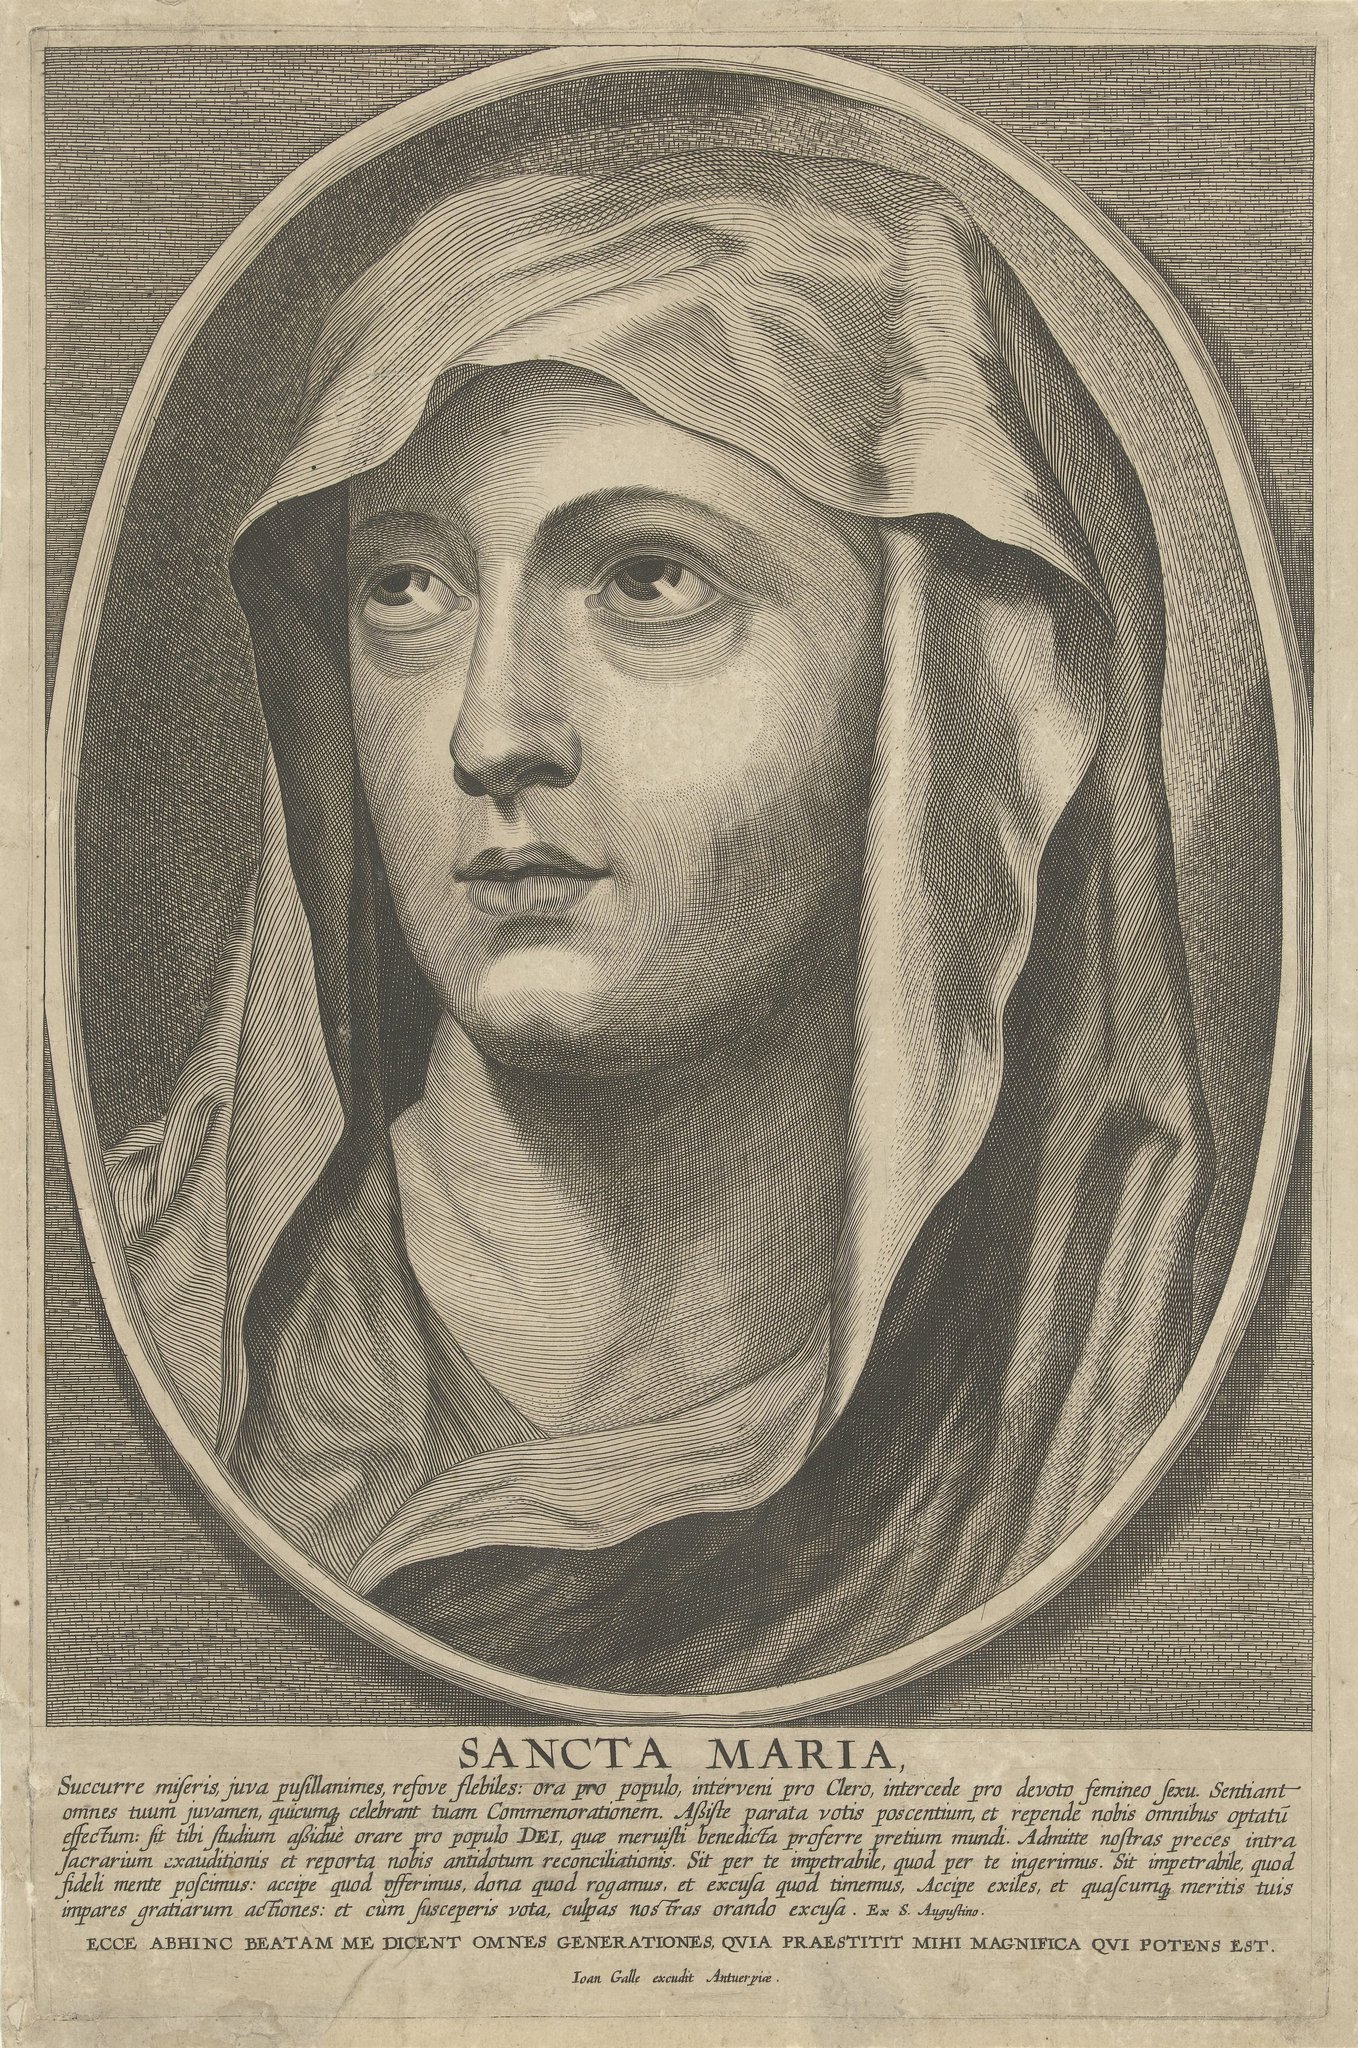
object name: print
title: Portret van de heilige maagd Maria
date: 1627-1676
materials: paper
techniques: engraving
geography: antwerp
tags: 'portraits' of mary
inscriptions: collector's mark: Lugt 240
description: Portret van Maria, in ovaal. Onder het portret een Latijnse tekst van de H. Augustinus.